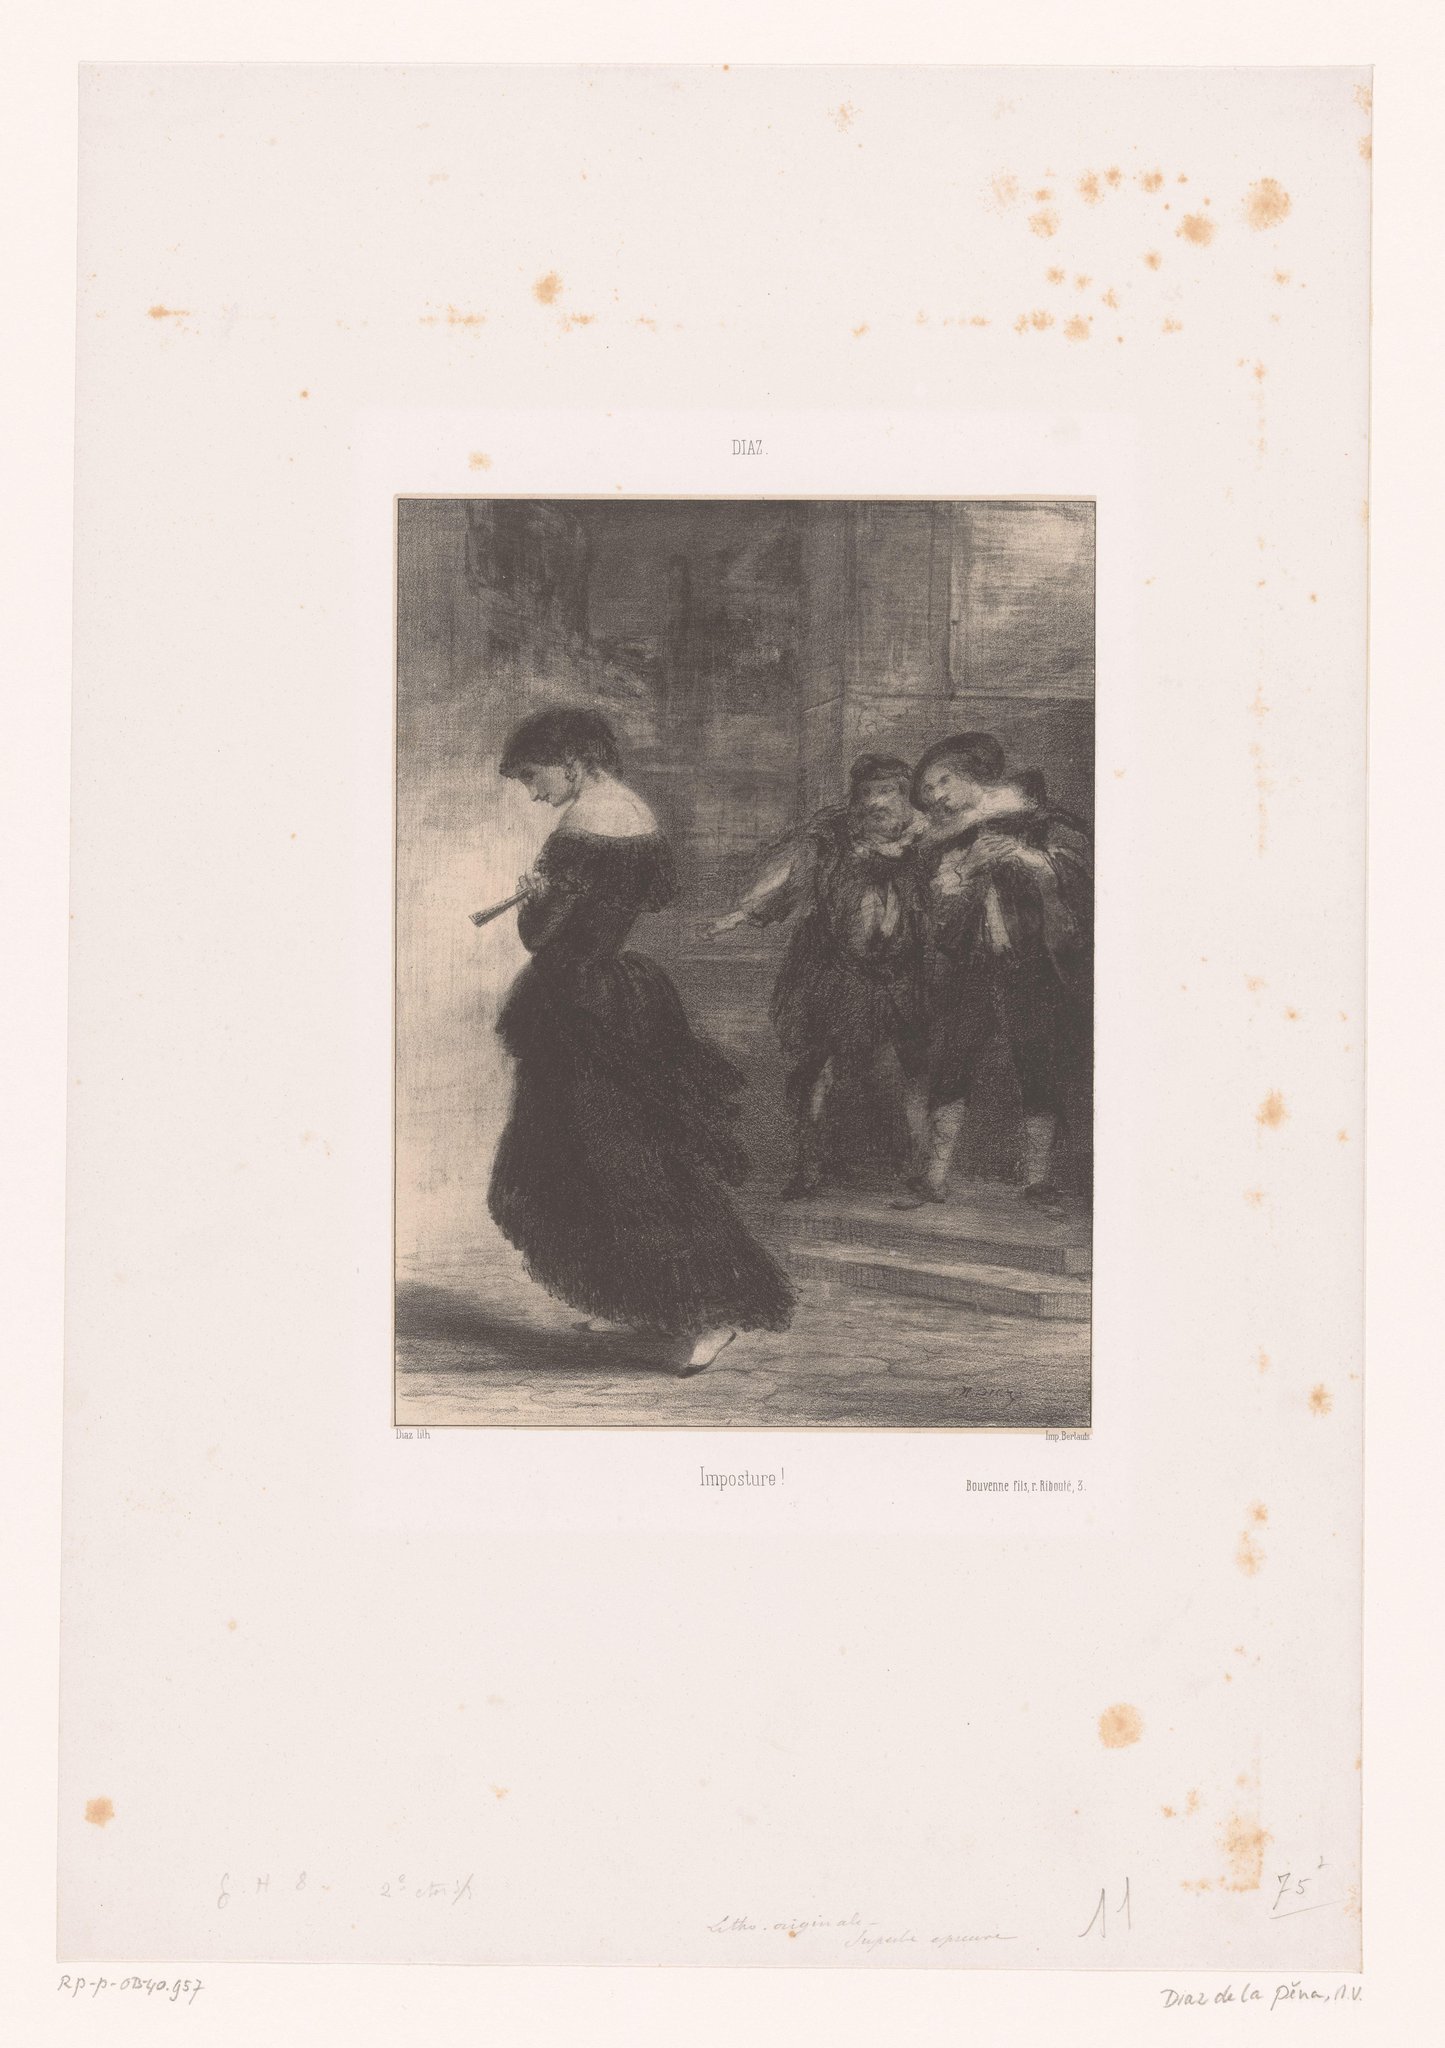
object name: print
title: Vrouw wordt op straat bekeken door twee mannen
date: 1849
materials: paper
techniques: lithograph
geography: paris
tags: peeping, voyeur, pursuit of a woman, prowling, fashionable woman, 'belle'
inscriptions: collector's mark: Lugt 2228a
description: Prent gebruikt voor: L'Artiste, revue de Paris, 1849, 5e serie, dl. 2, p. 103. De prent heeft hier de titel: Les joies du mensonge.